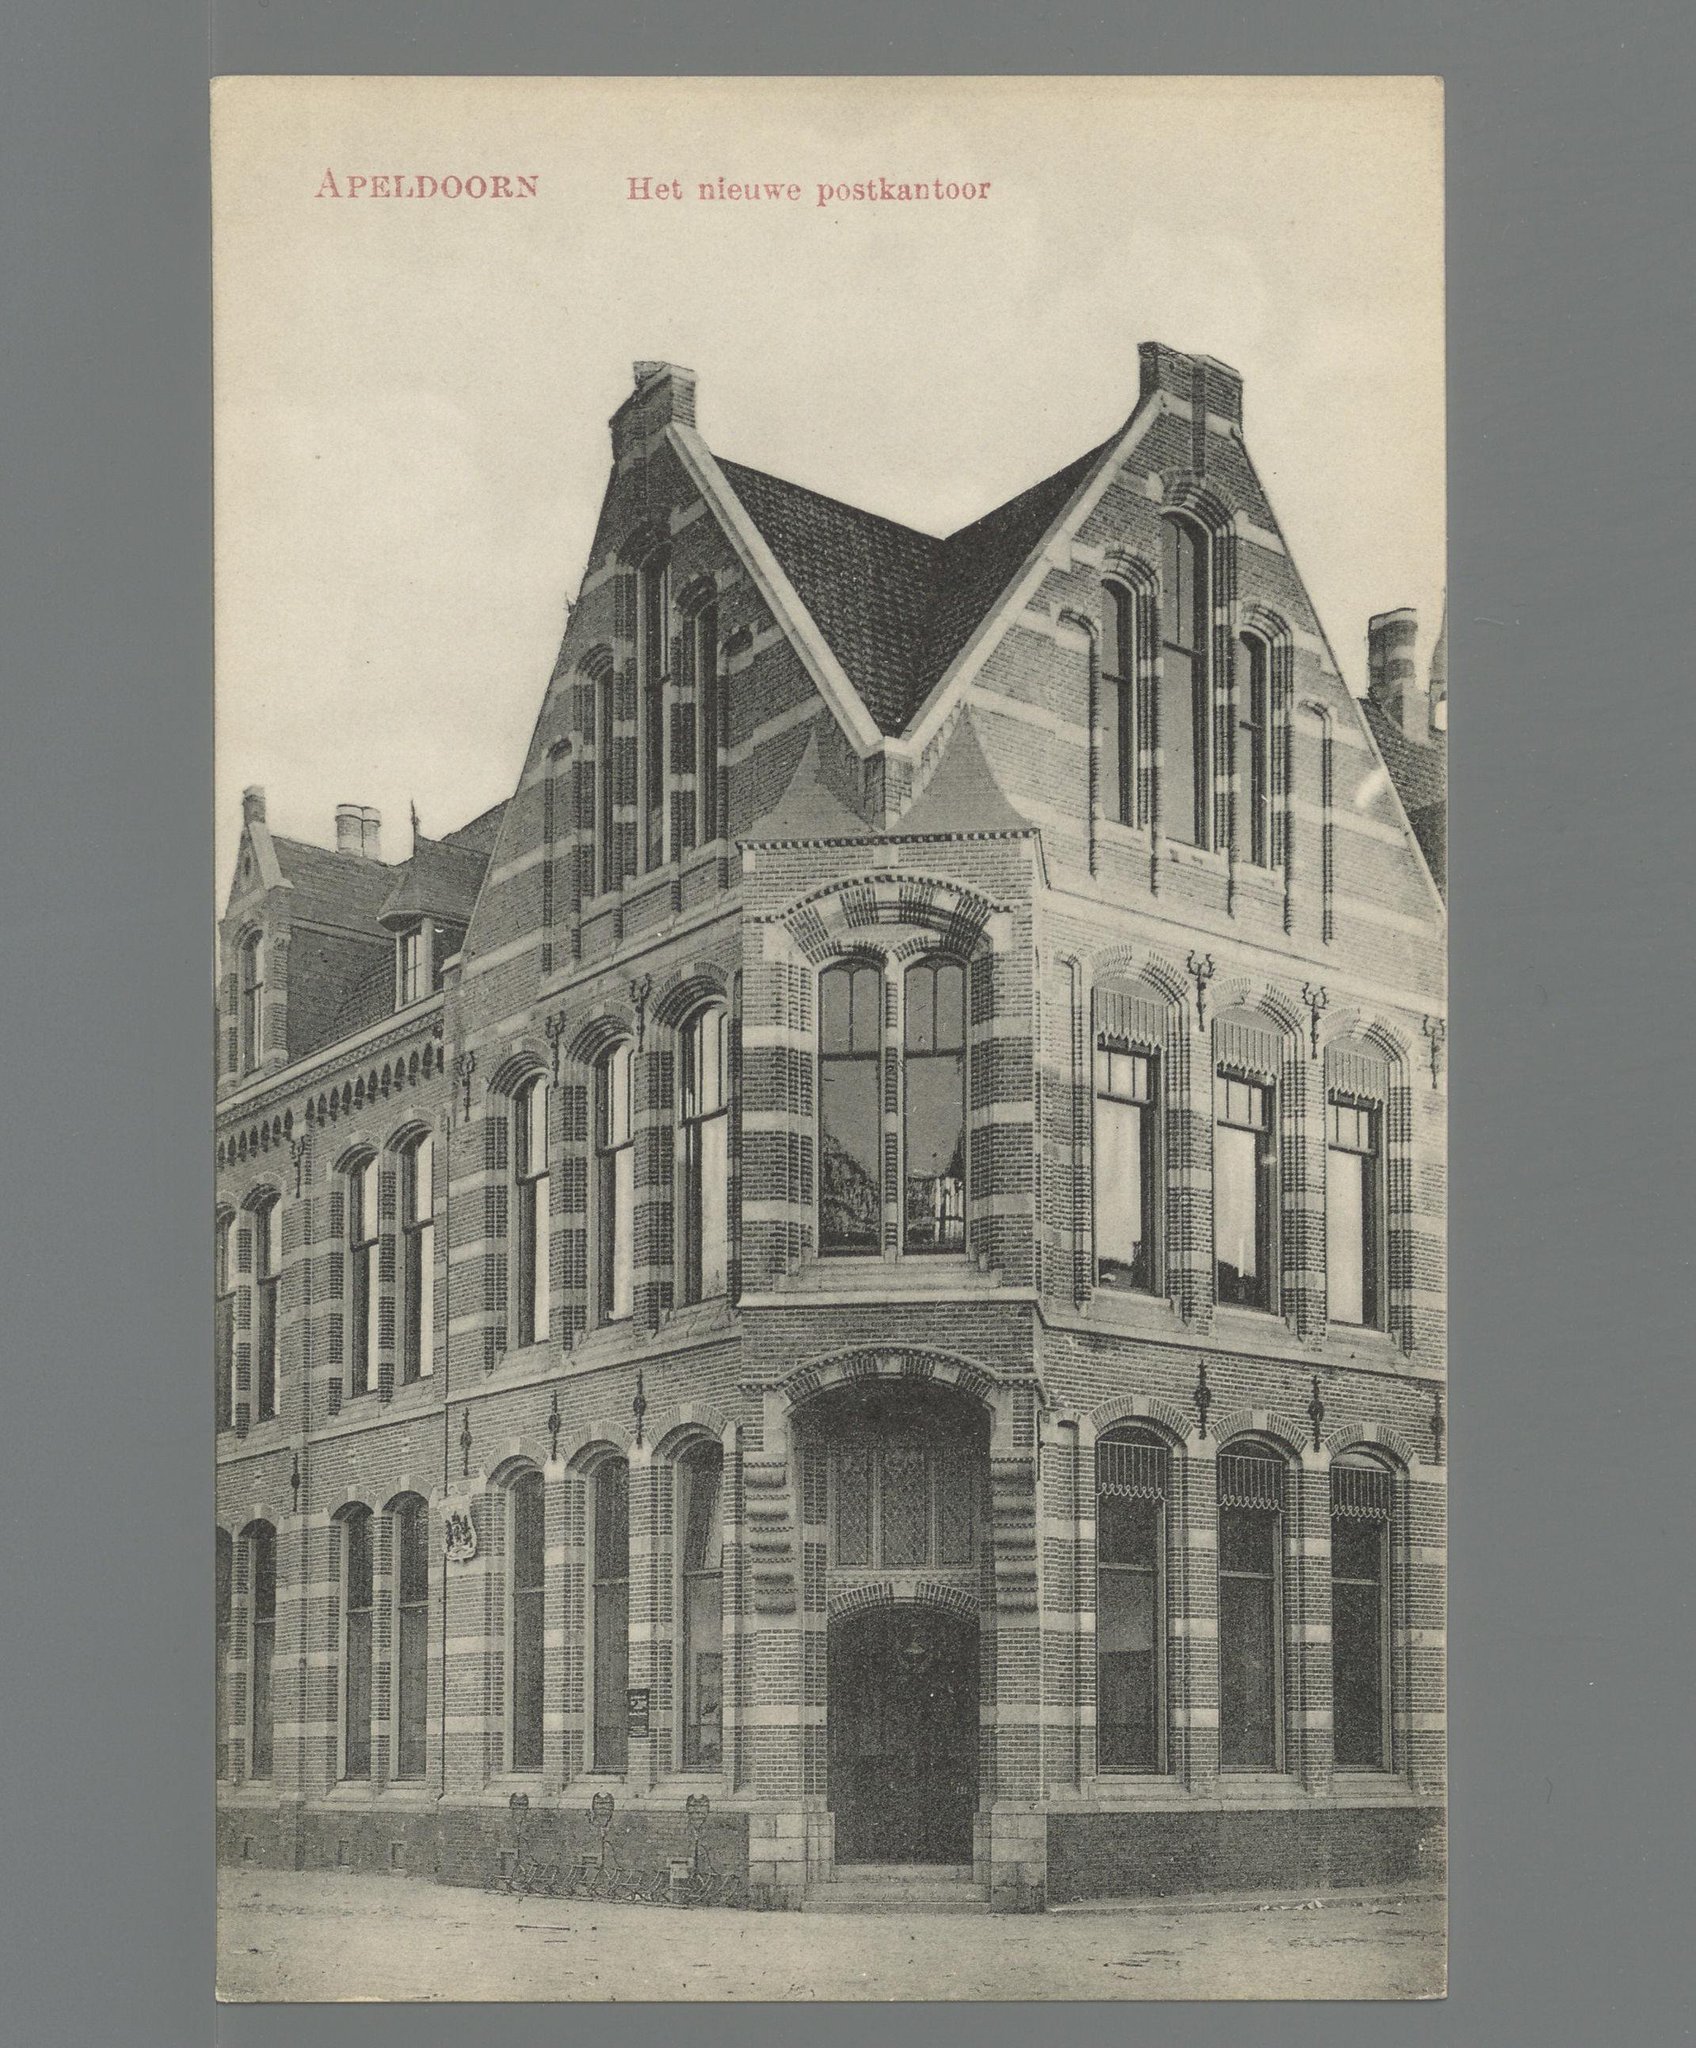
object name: photomechanical print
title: Apeldoorn. Het nieuwe postkantoor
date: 1905-1926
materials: cardboard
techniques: photograph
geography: apeldoorn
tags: post-office